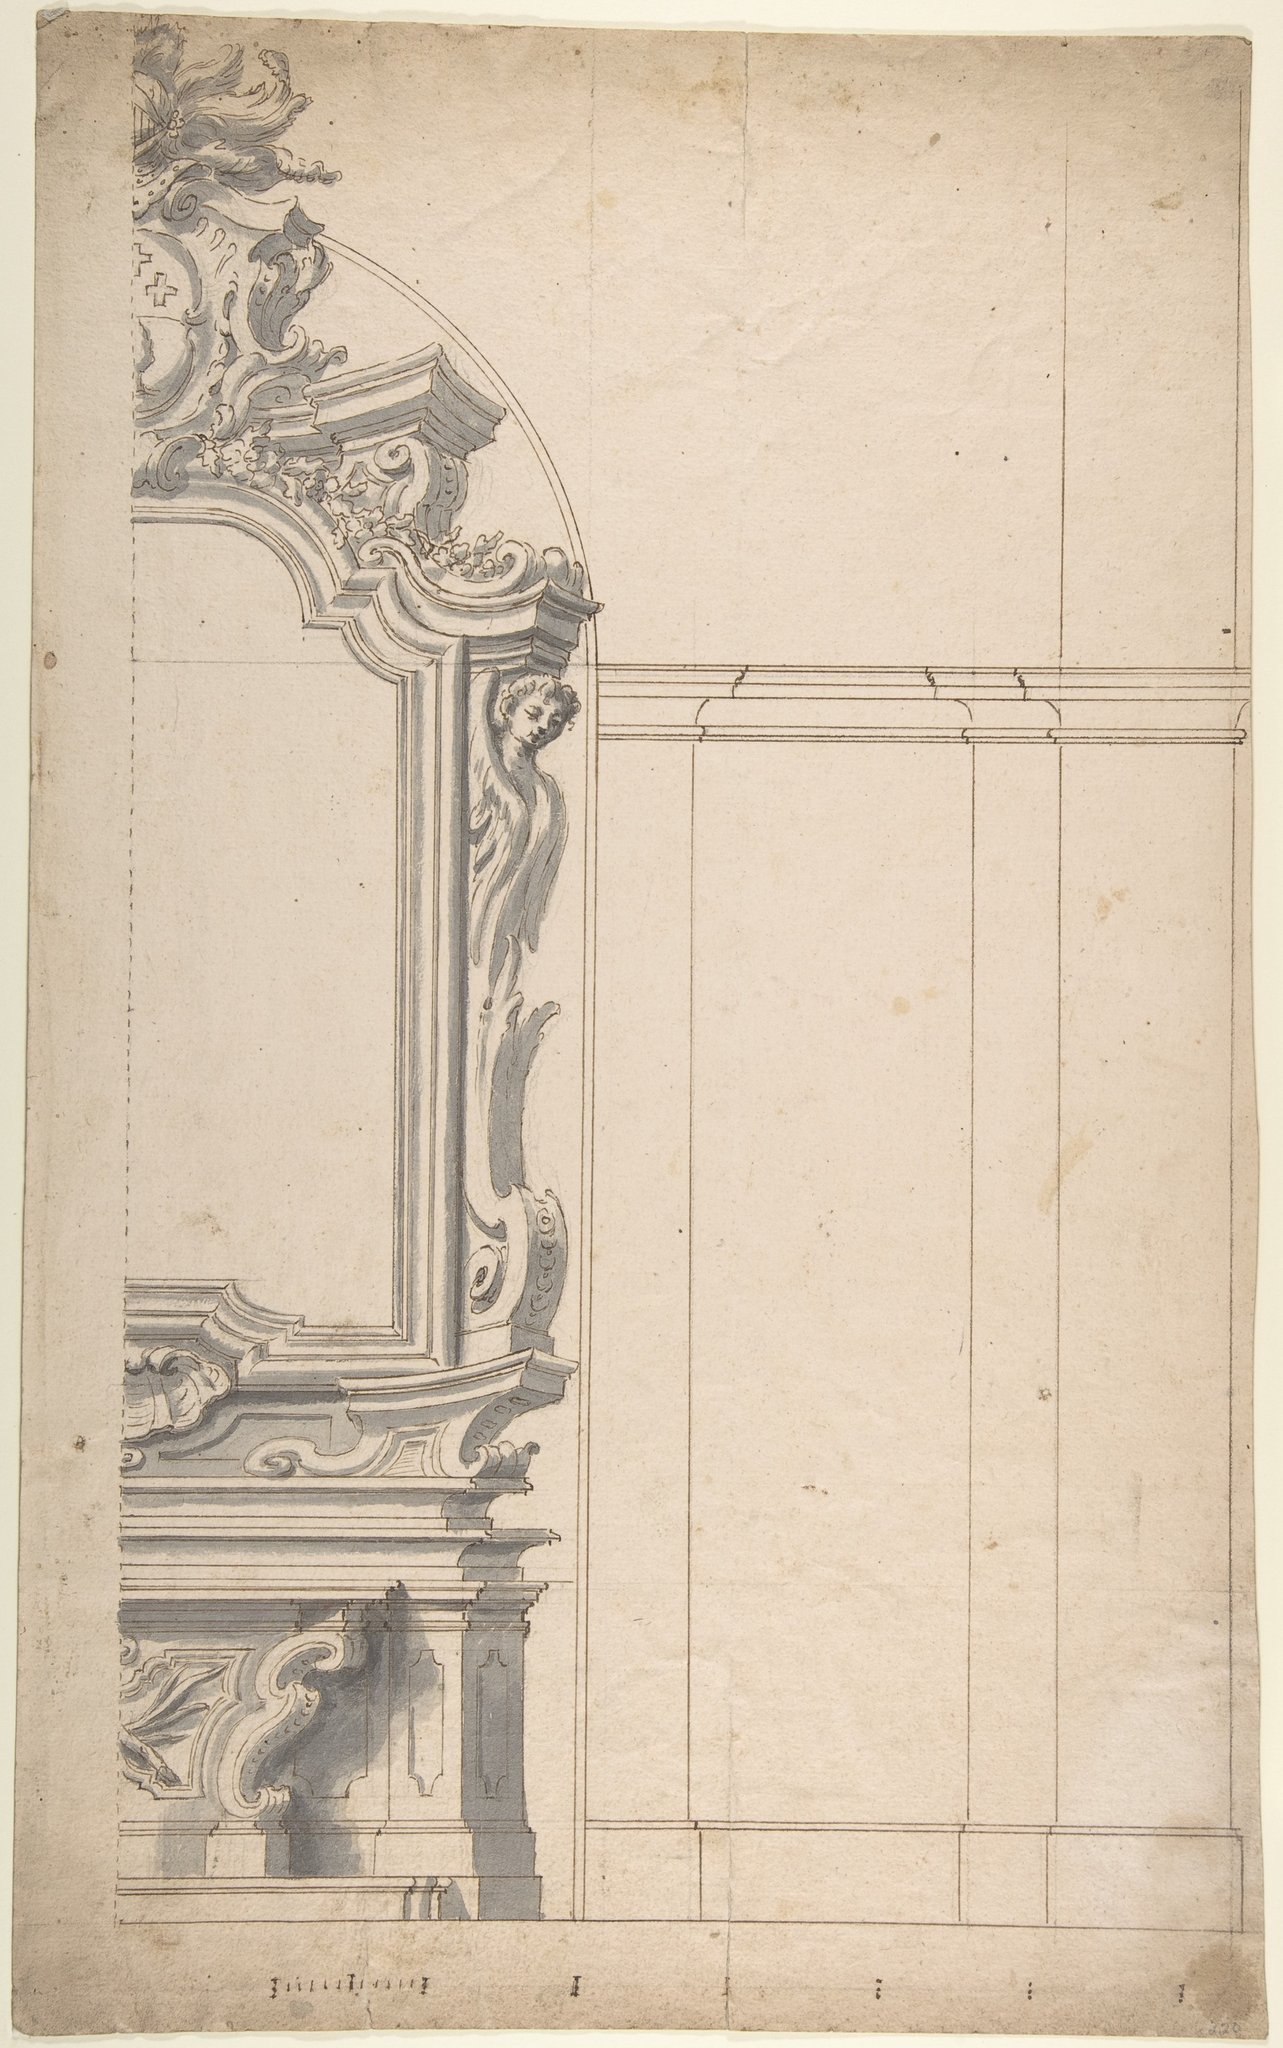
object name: drawing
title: Design for one half of an Altar with a Pilastered Wall at the Right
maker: anonymous, italian, piedmontese, 18th century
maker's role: artist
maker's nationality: italian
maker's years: 1700-1800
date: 1700-1780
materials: graphite, ink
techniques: brush, pen, wash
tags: architecture,altars